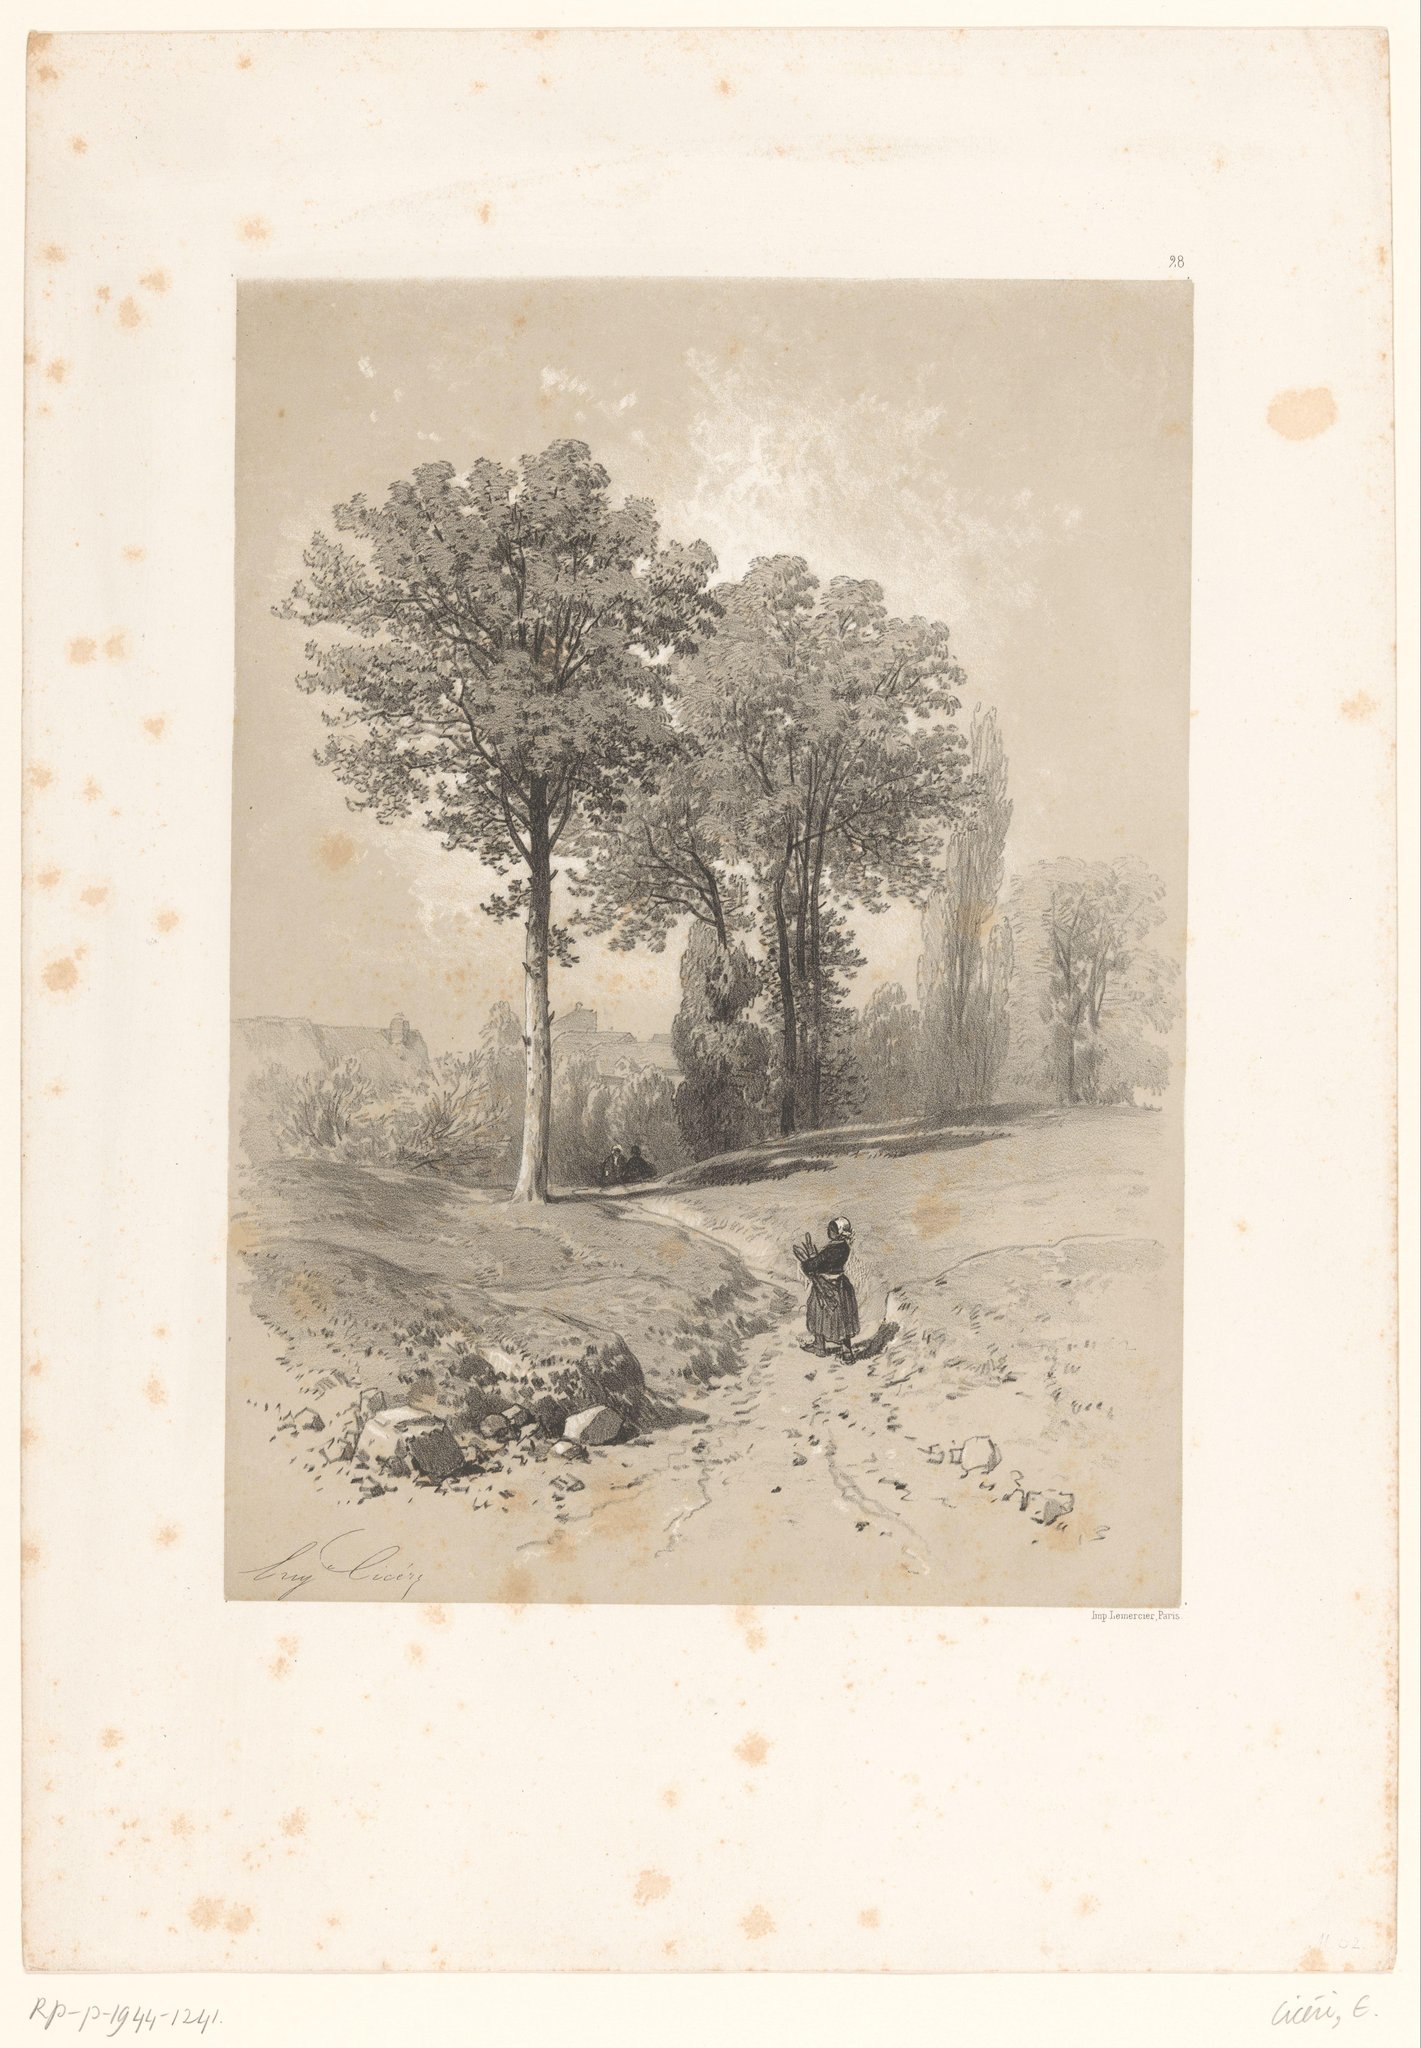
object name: print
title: Vrouw met sprokkelhout op pad bij bomen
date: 1835-1890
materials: paper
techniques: tone lithography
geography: paris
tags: trees, road, path, prospect of village, silhouette of village (+ city(-scape) with figures, staffage)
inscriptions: collector's mark: Lugt 2228a